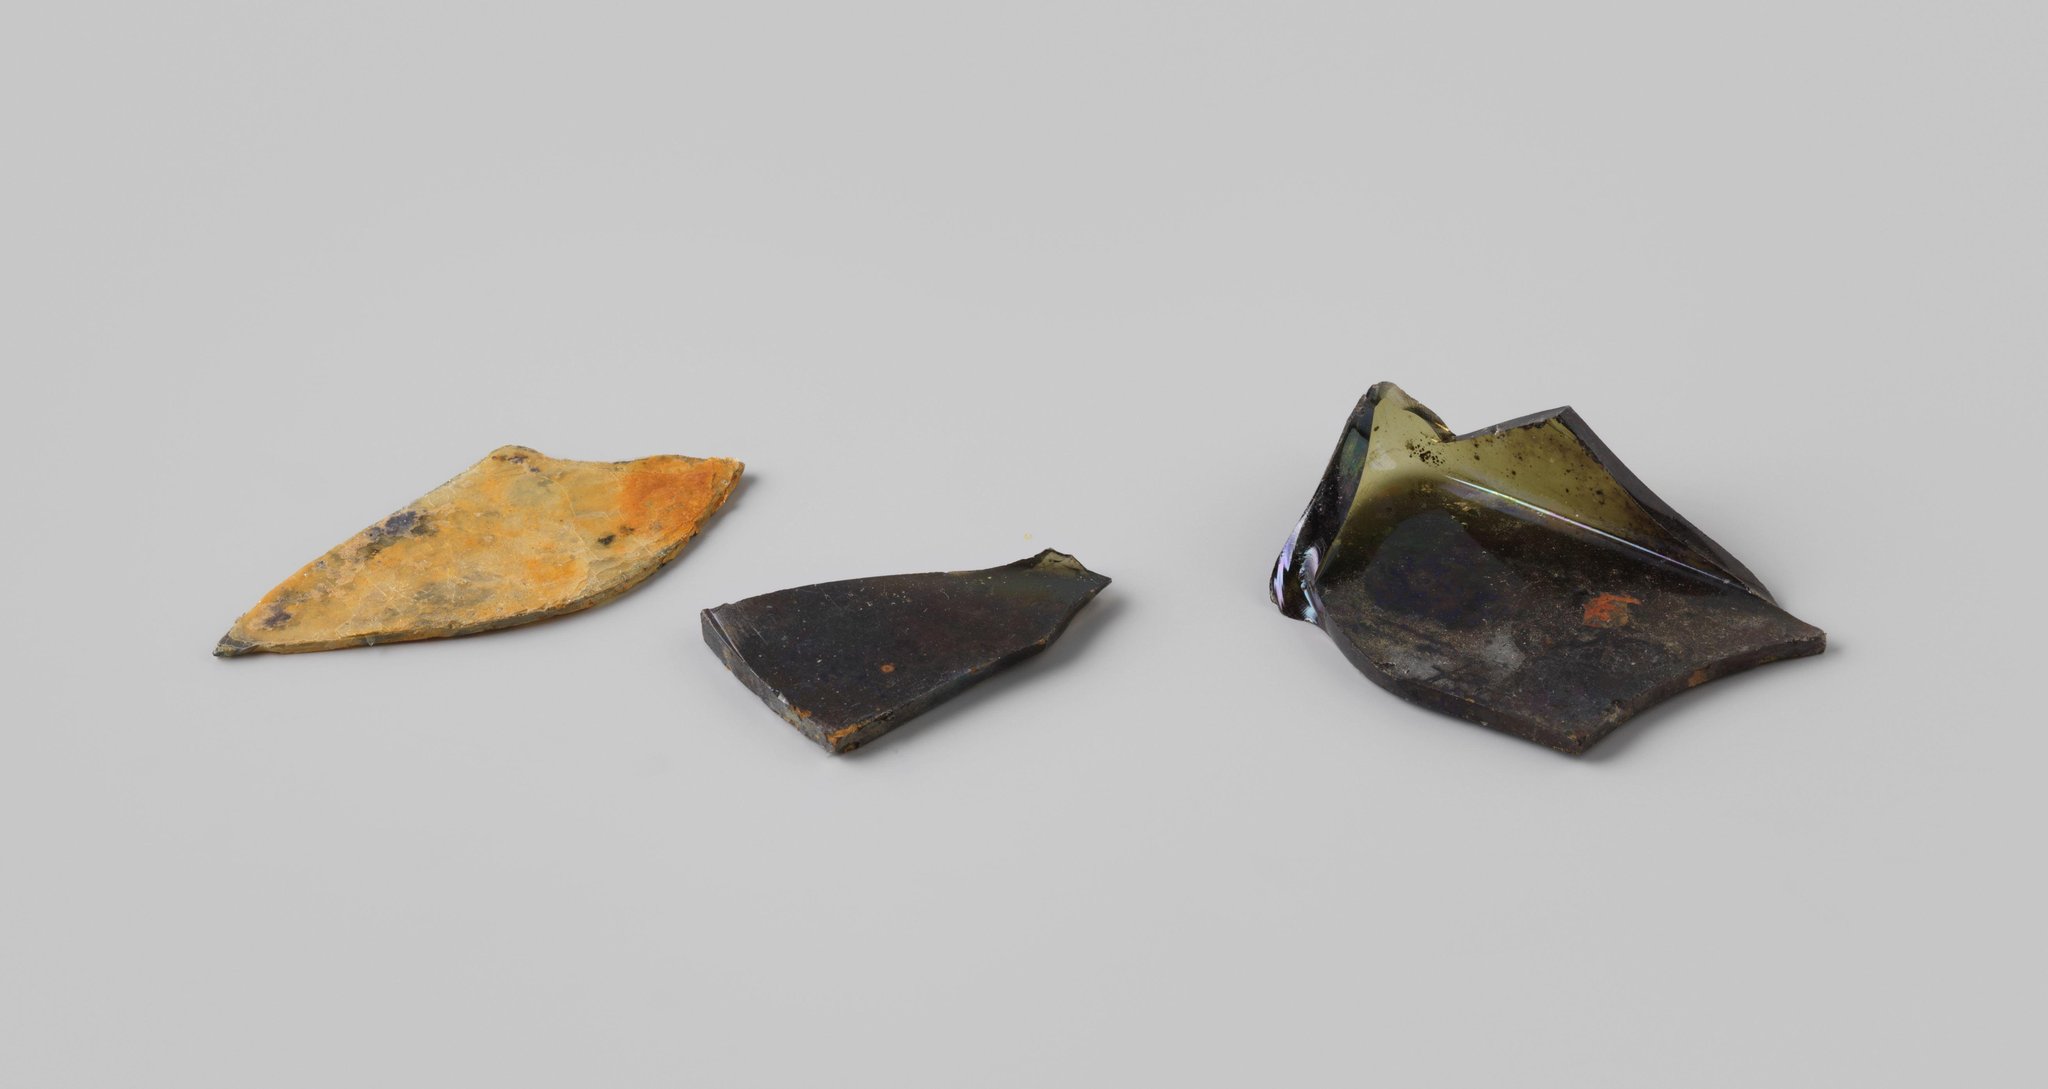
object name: case bottle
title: Scherven van kelderflessen uit het wrak van de Oost-Indiëvaarder 't Vliegend Hart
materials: glass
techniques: green glass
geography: middelburg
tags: 't vliegend hart (schip), verenigde oostindische compagnie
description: Scherf van de buik van een vierkante kelderfles bij de nek, van groen glas maar paarsig verkleurd. Nog een soortgelijke scherf. En een derde soortgelijke scherf maar dan geelbruin. Case bottle.